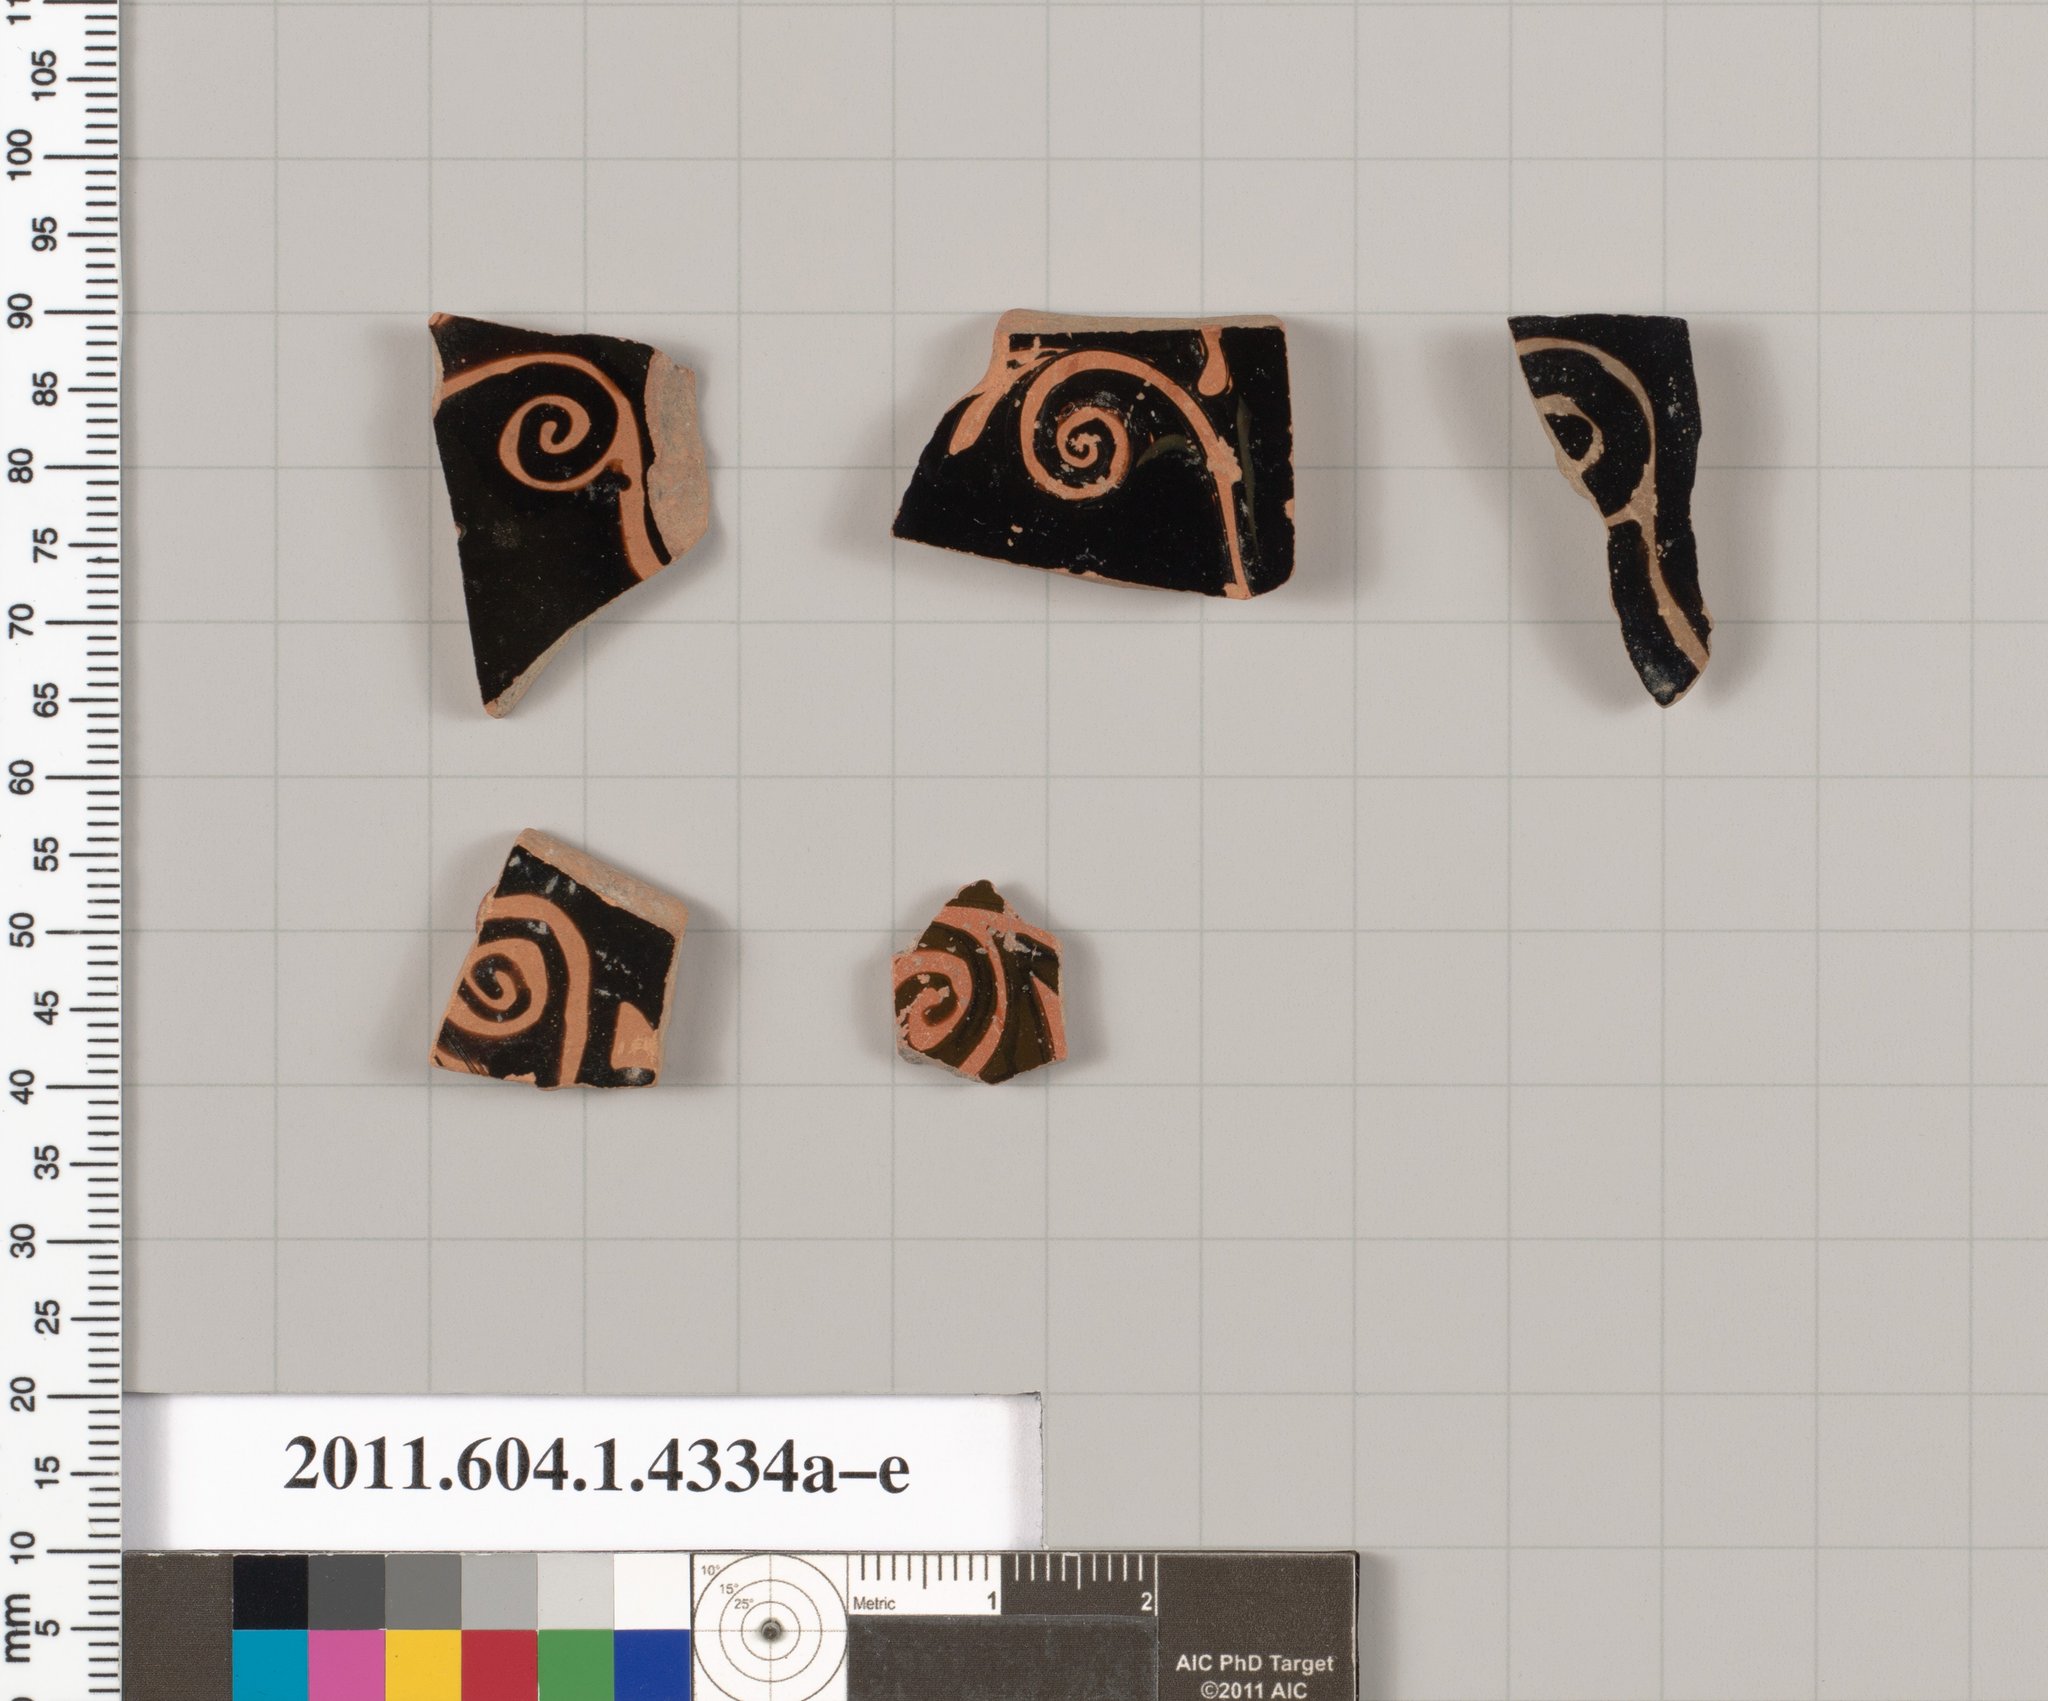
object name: kylix fragment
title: Terracotta fragments of kylikes (drinking cups)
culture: greek, attic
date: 500-451 BCE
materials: terracotta